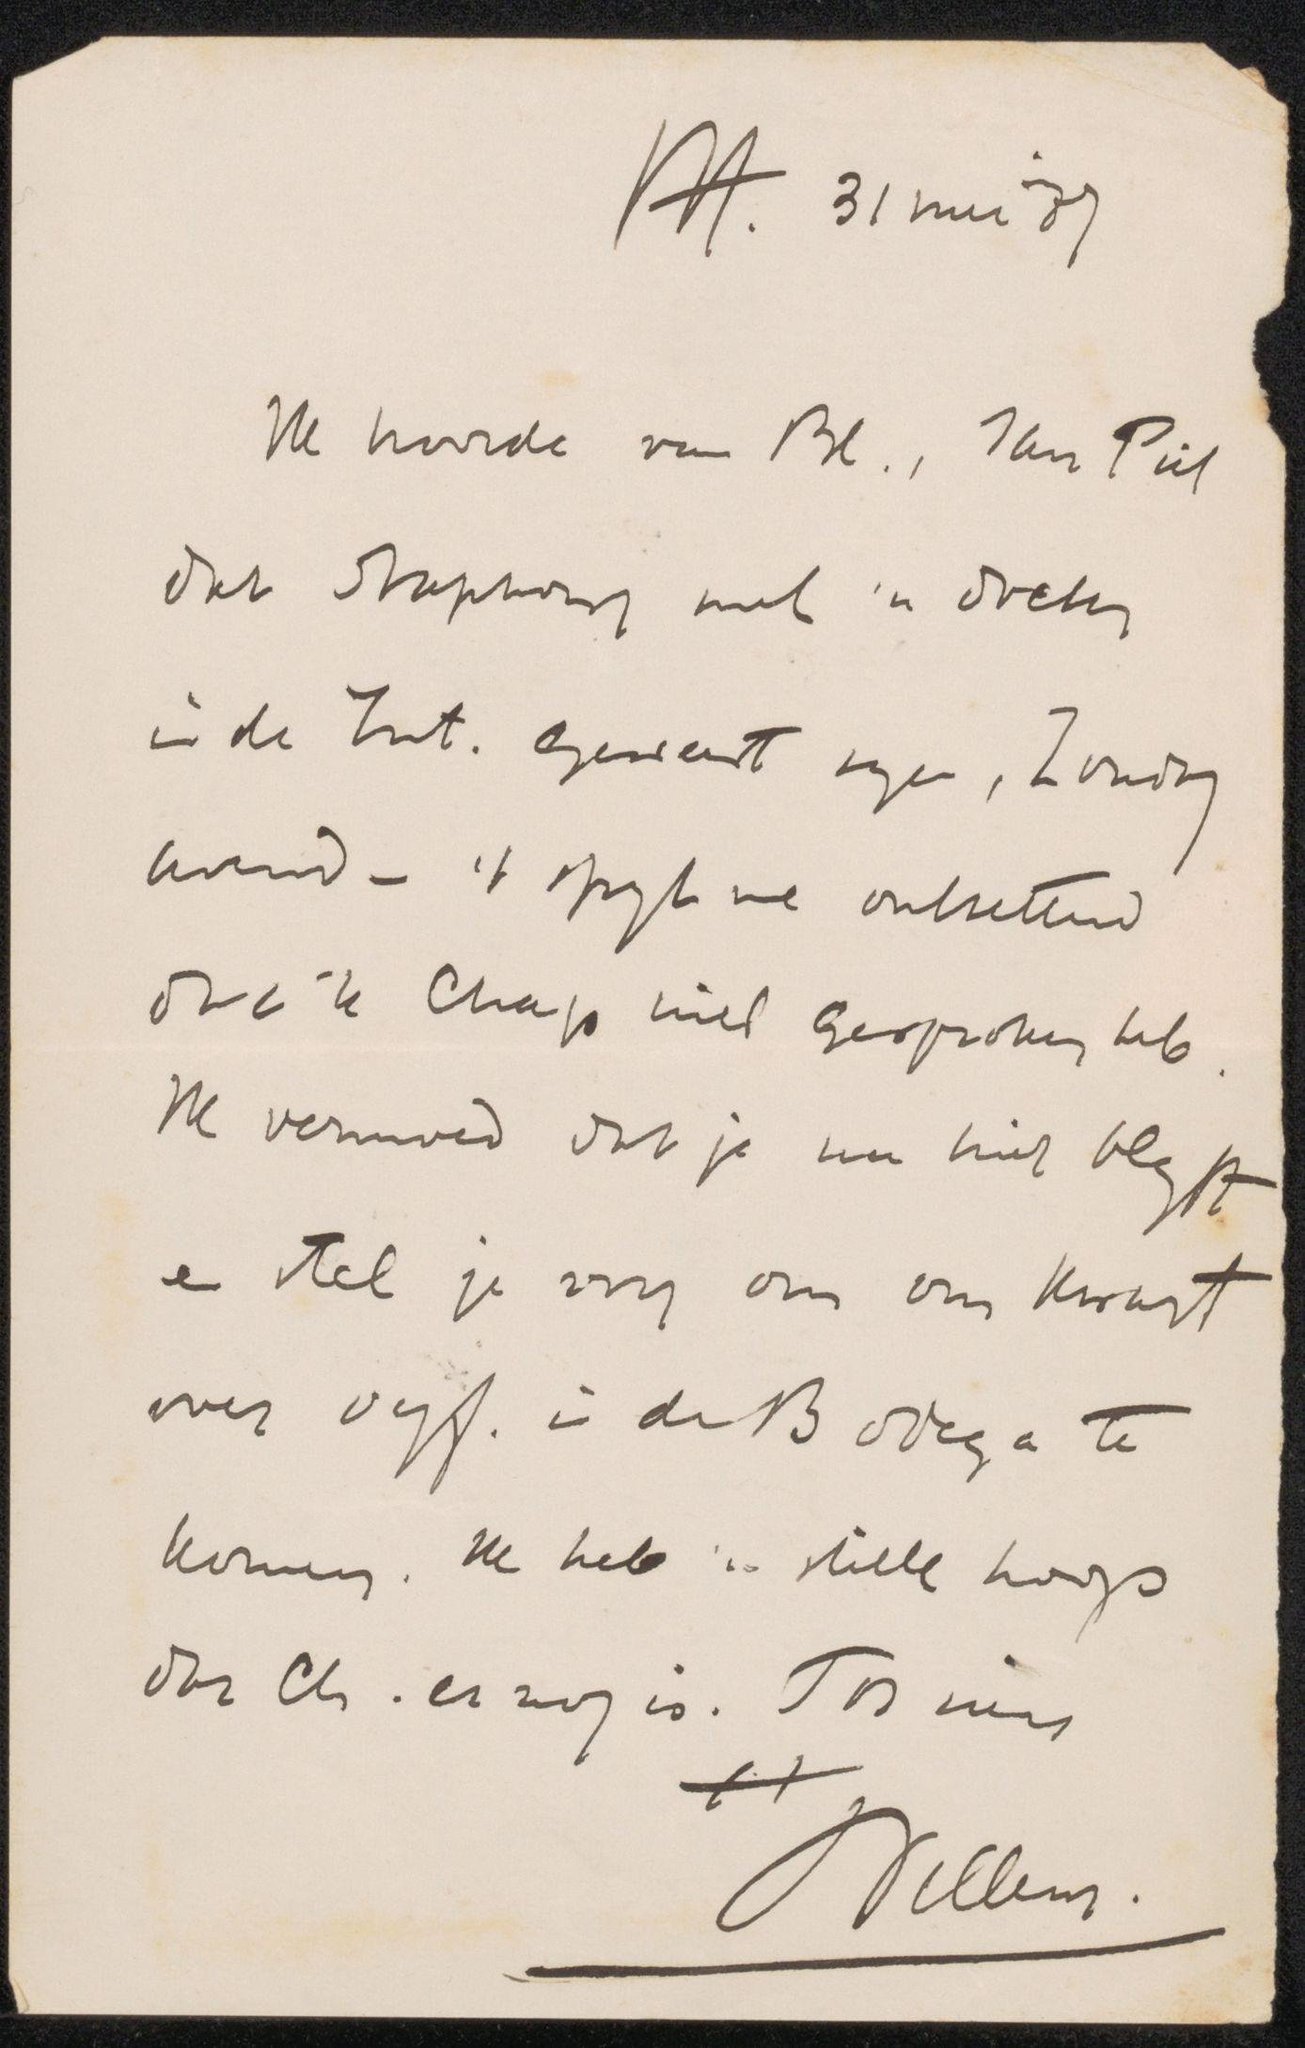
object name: letter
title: Brief aan Jan Veth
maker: willem witsen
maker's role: draughtsman, painter, print maker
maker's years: 1860-1923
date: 1887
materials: ink, paper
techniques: pen, writing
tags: painter, print maker, draughtsman, designer, jan veth, dordrecht, amsterdam, chap van deventer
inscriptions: watermark, collector's mark: ‘RPK’